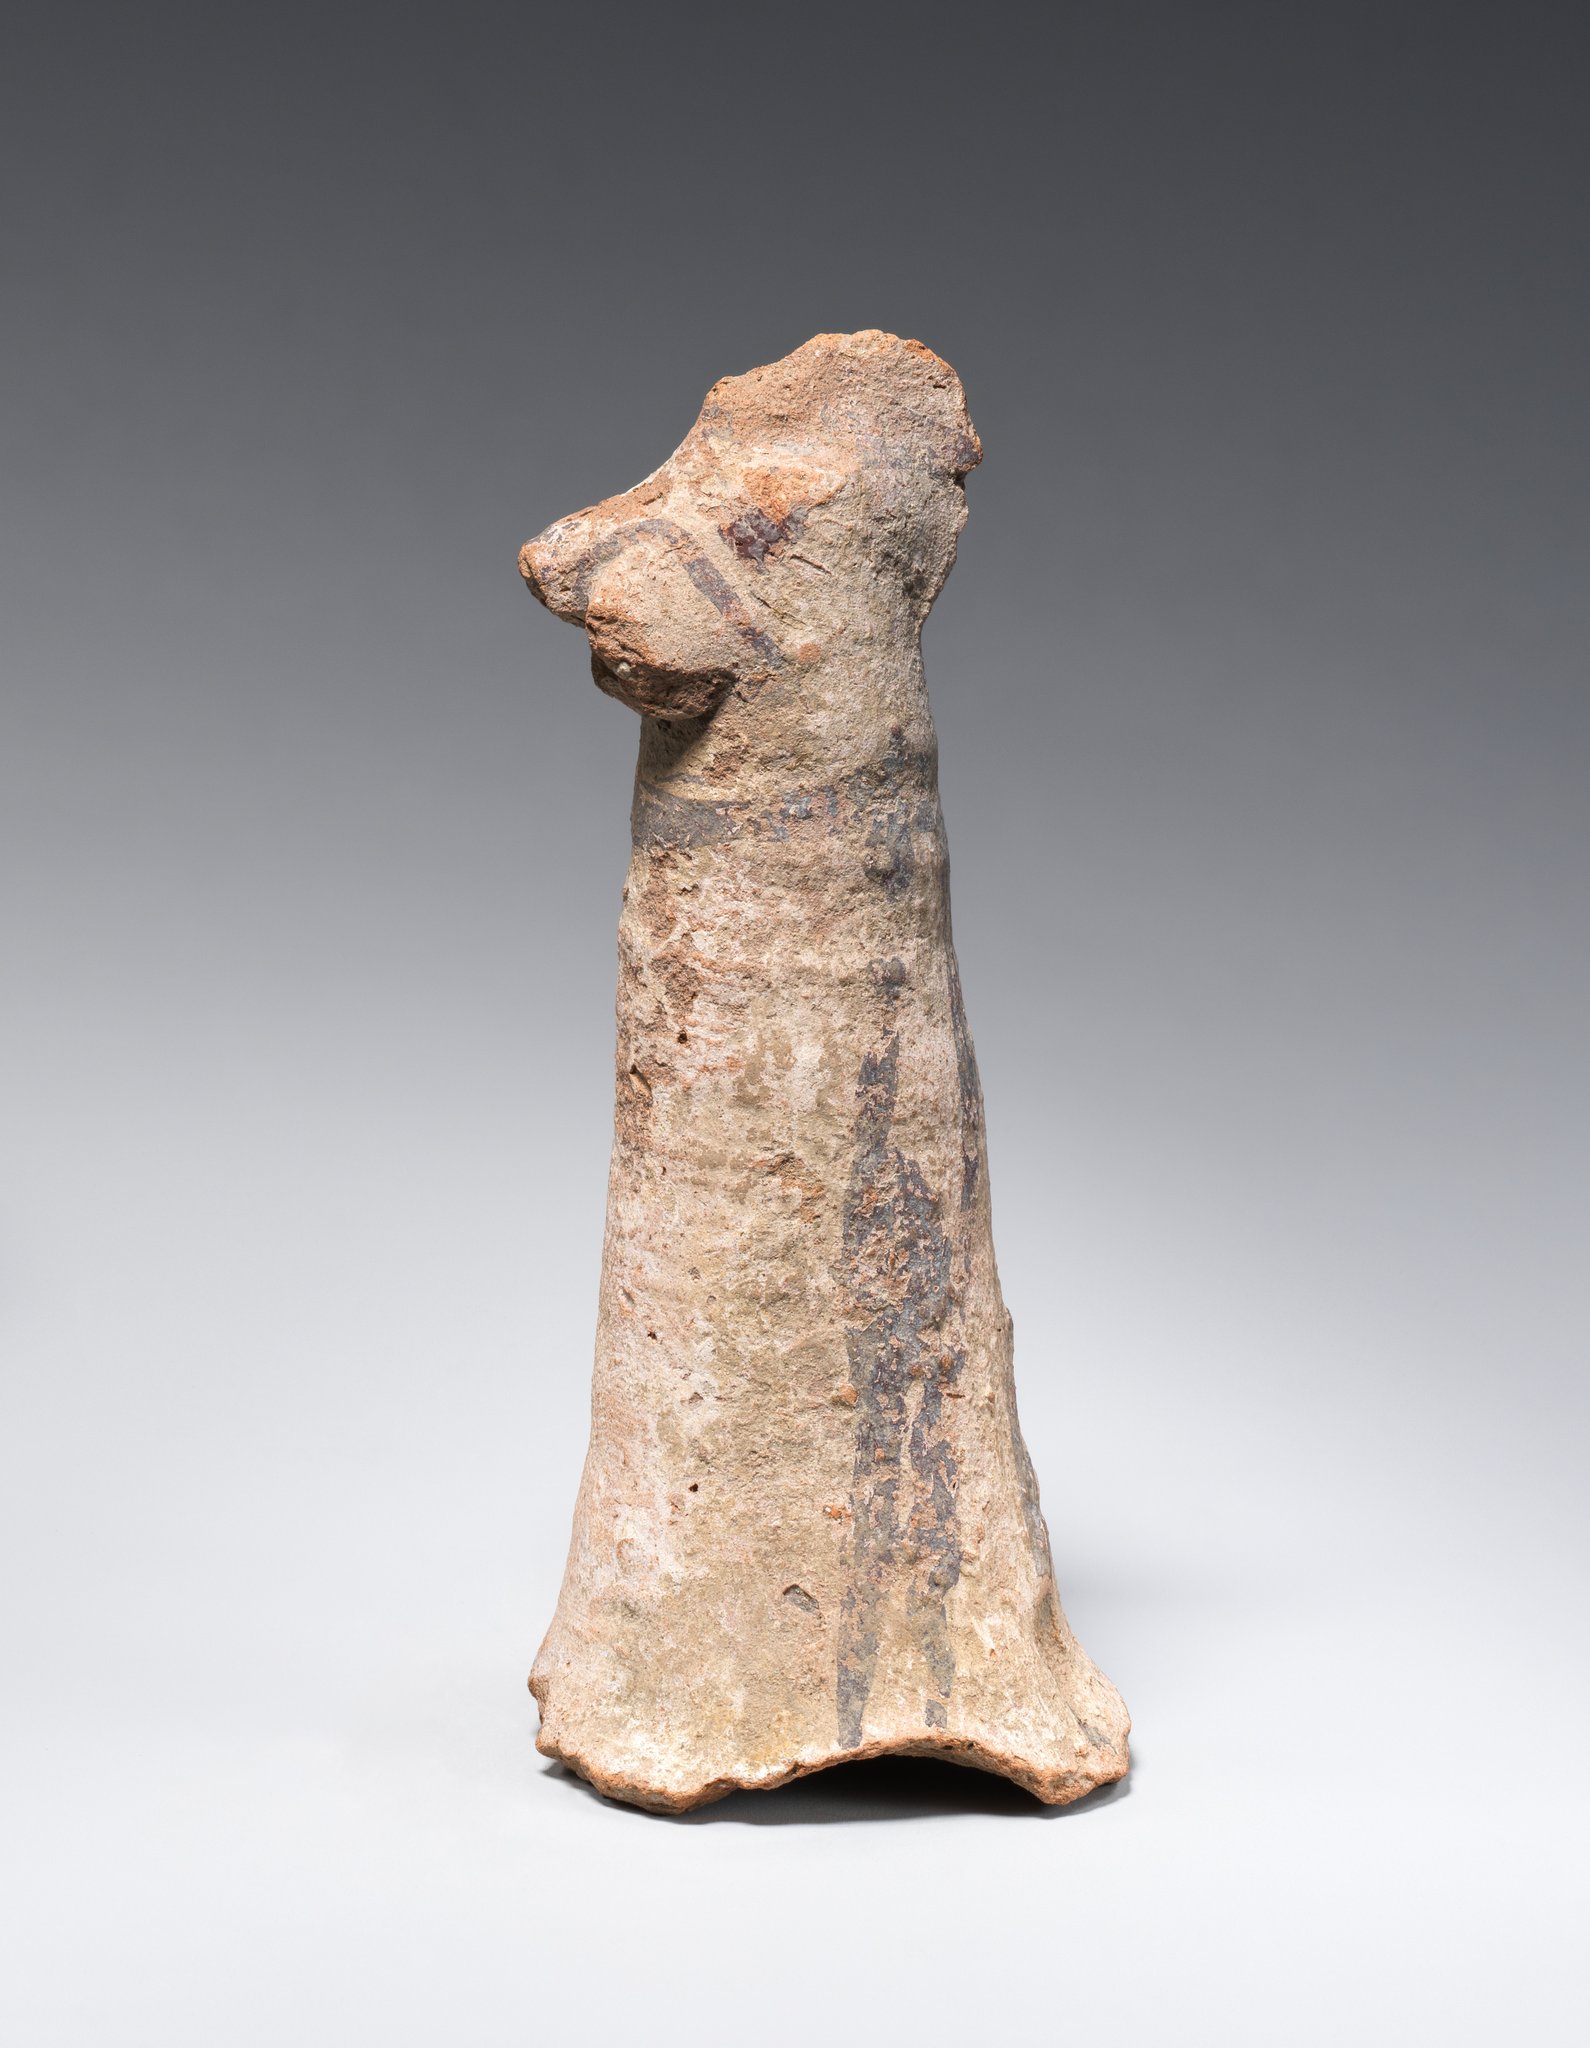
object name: figurine, animal, rooster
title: Figure of a Rooster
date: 306-30 BCE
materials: paint, pottery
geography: egypt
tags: animals